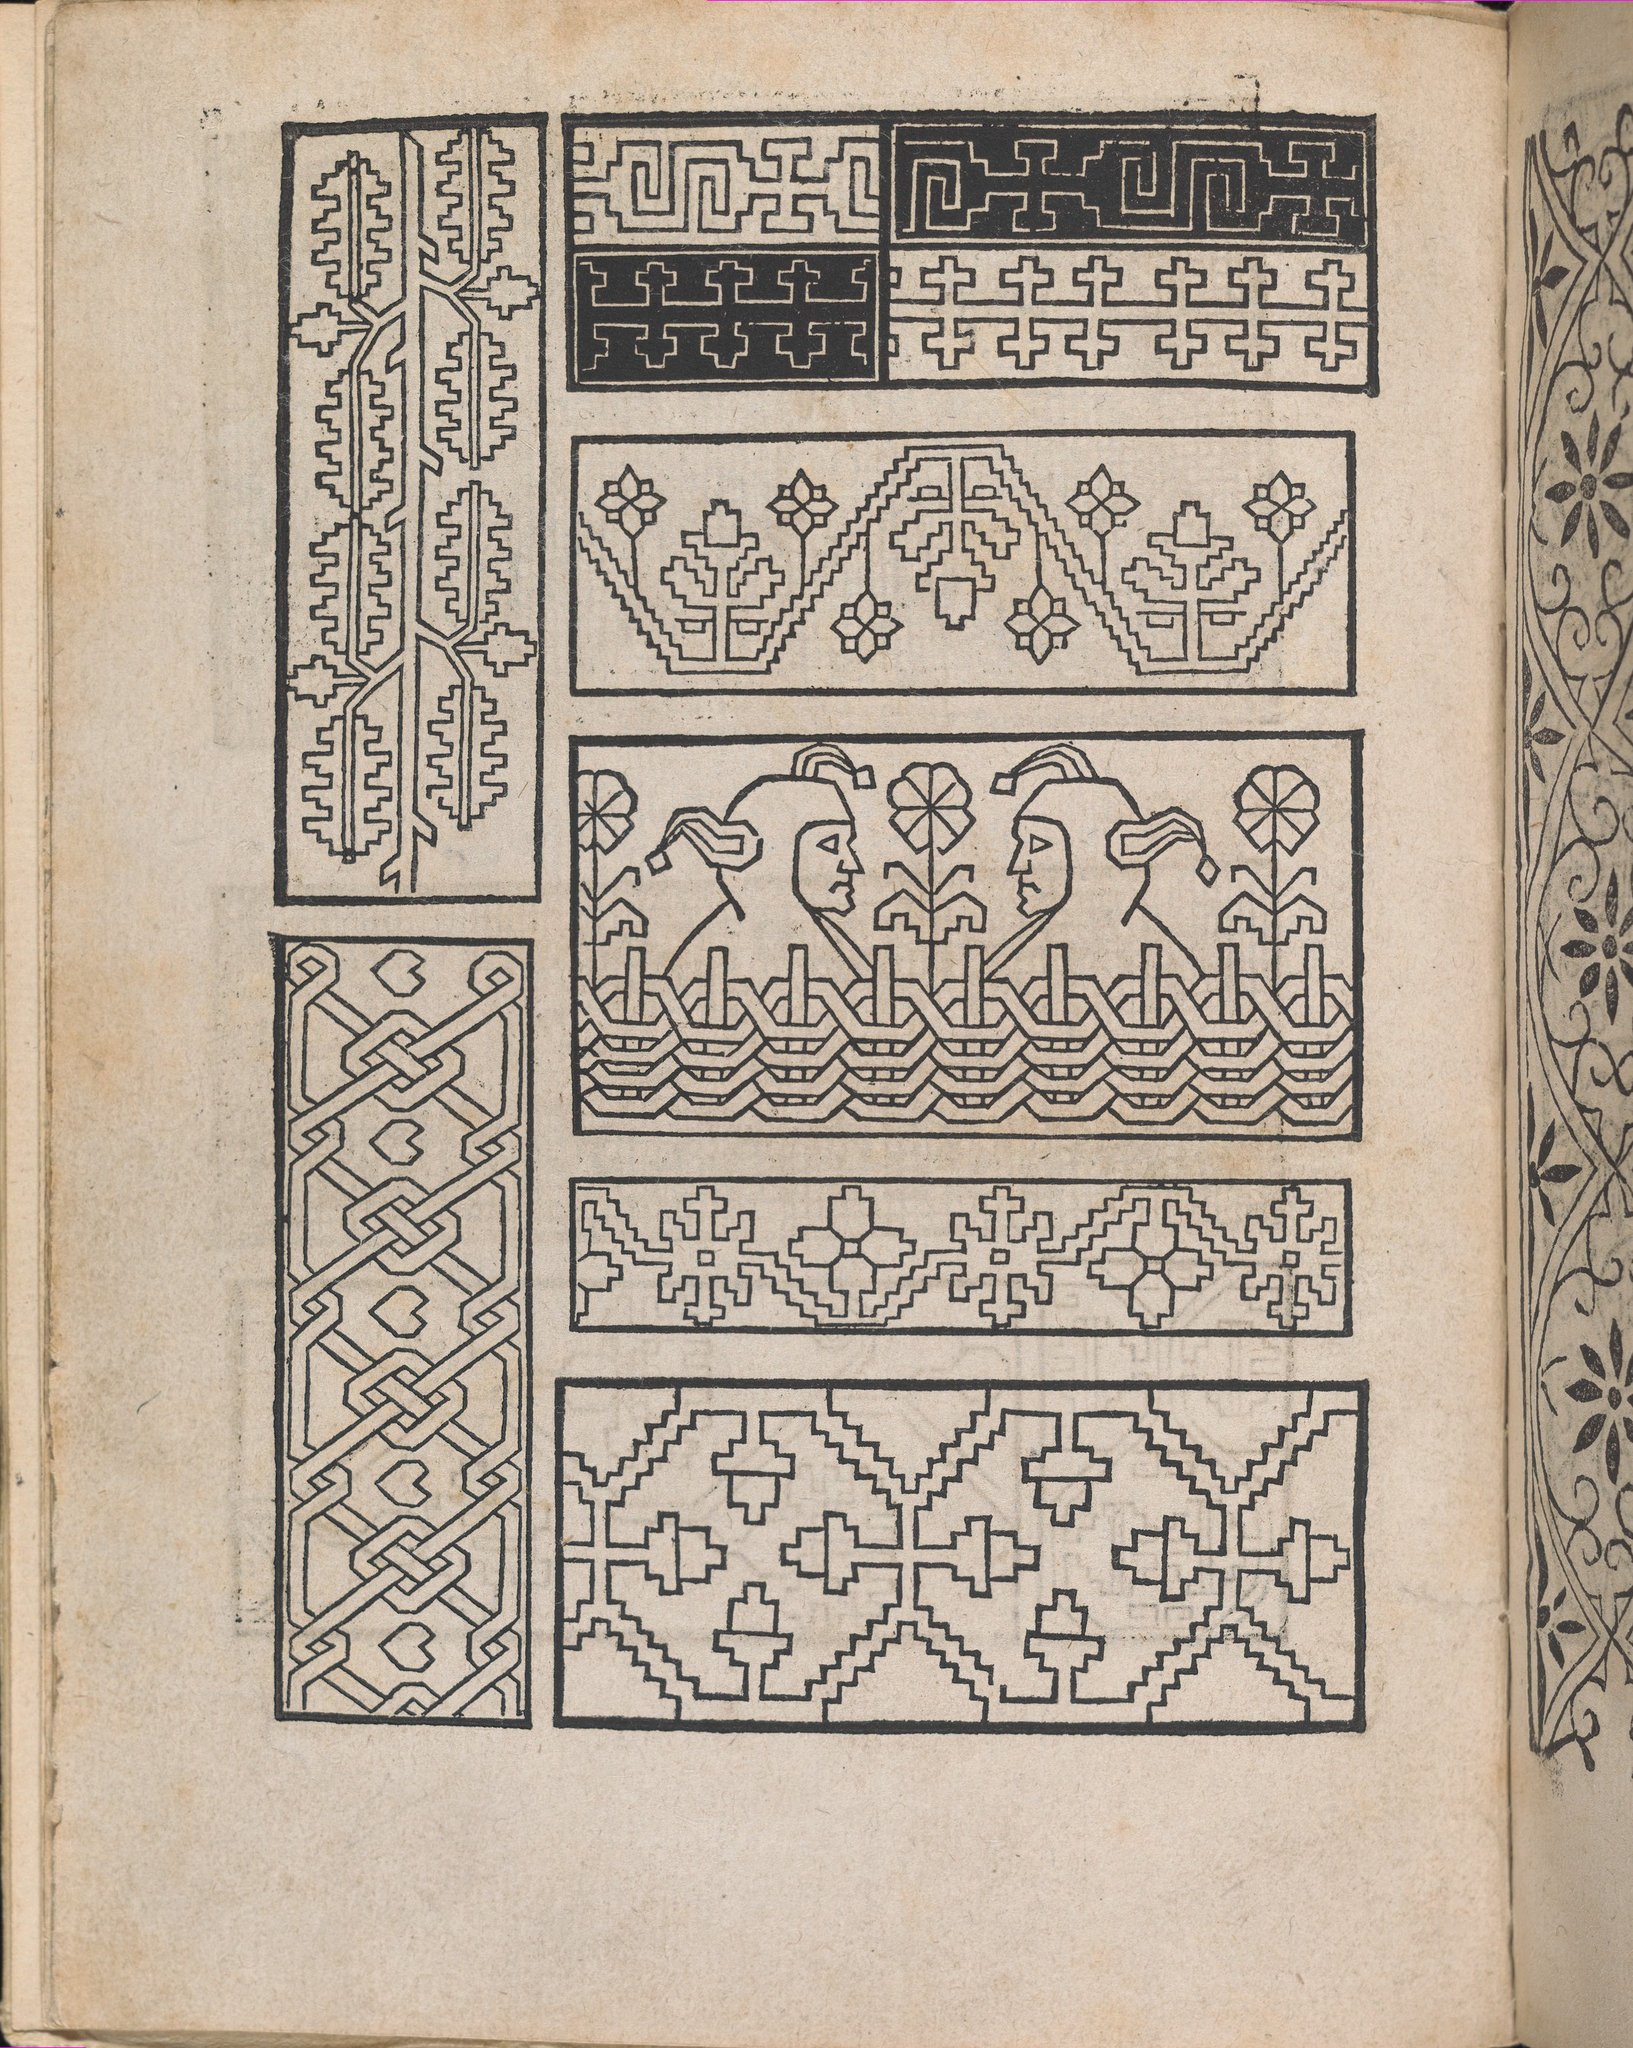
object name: book print ornament architecture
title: Modelbuch aller Art Nehens vn Stickens (Page 4v)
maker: christian egenolff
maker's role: publisher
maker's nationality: german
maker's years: 1502-1555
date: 1535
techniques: woodcut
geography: germany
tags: ornament